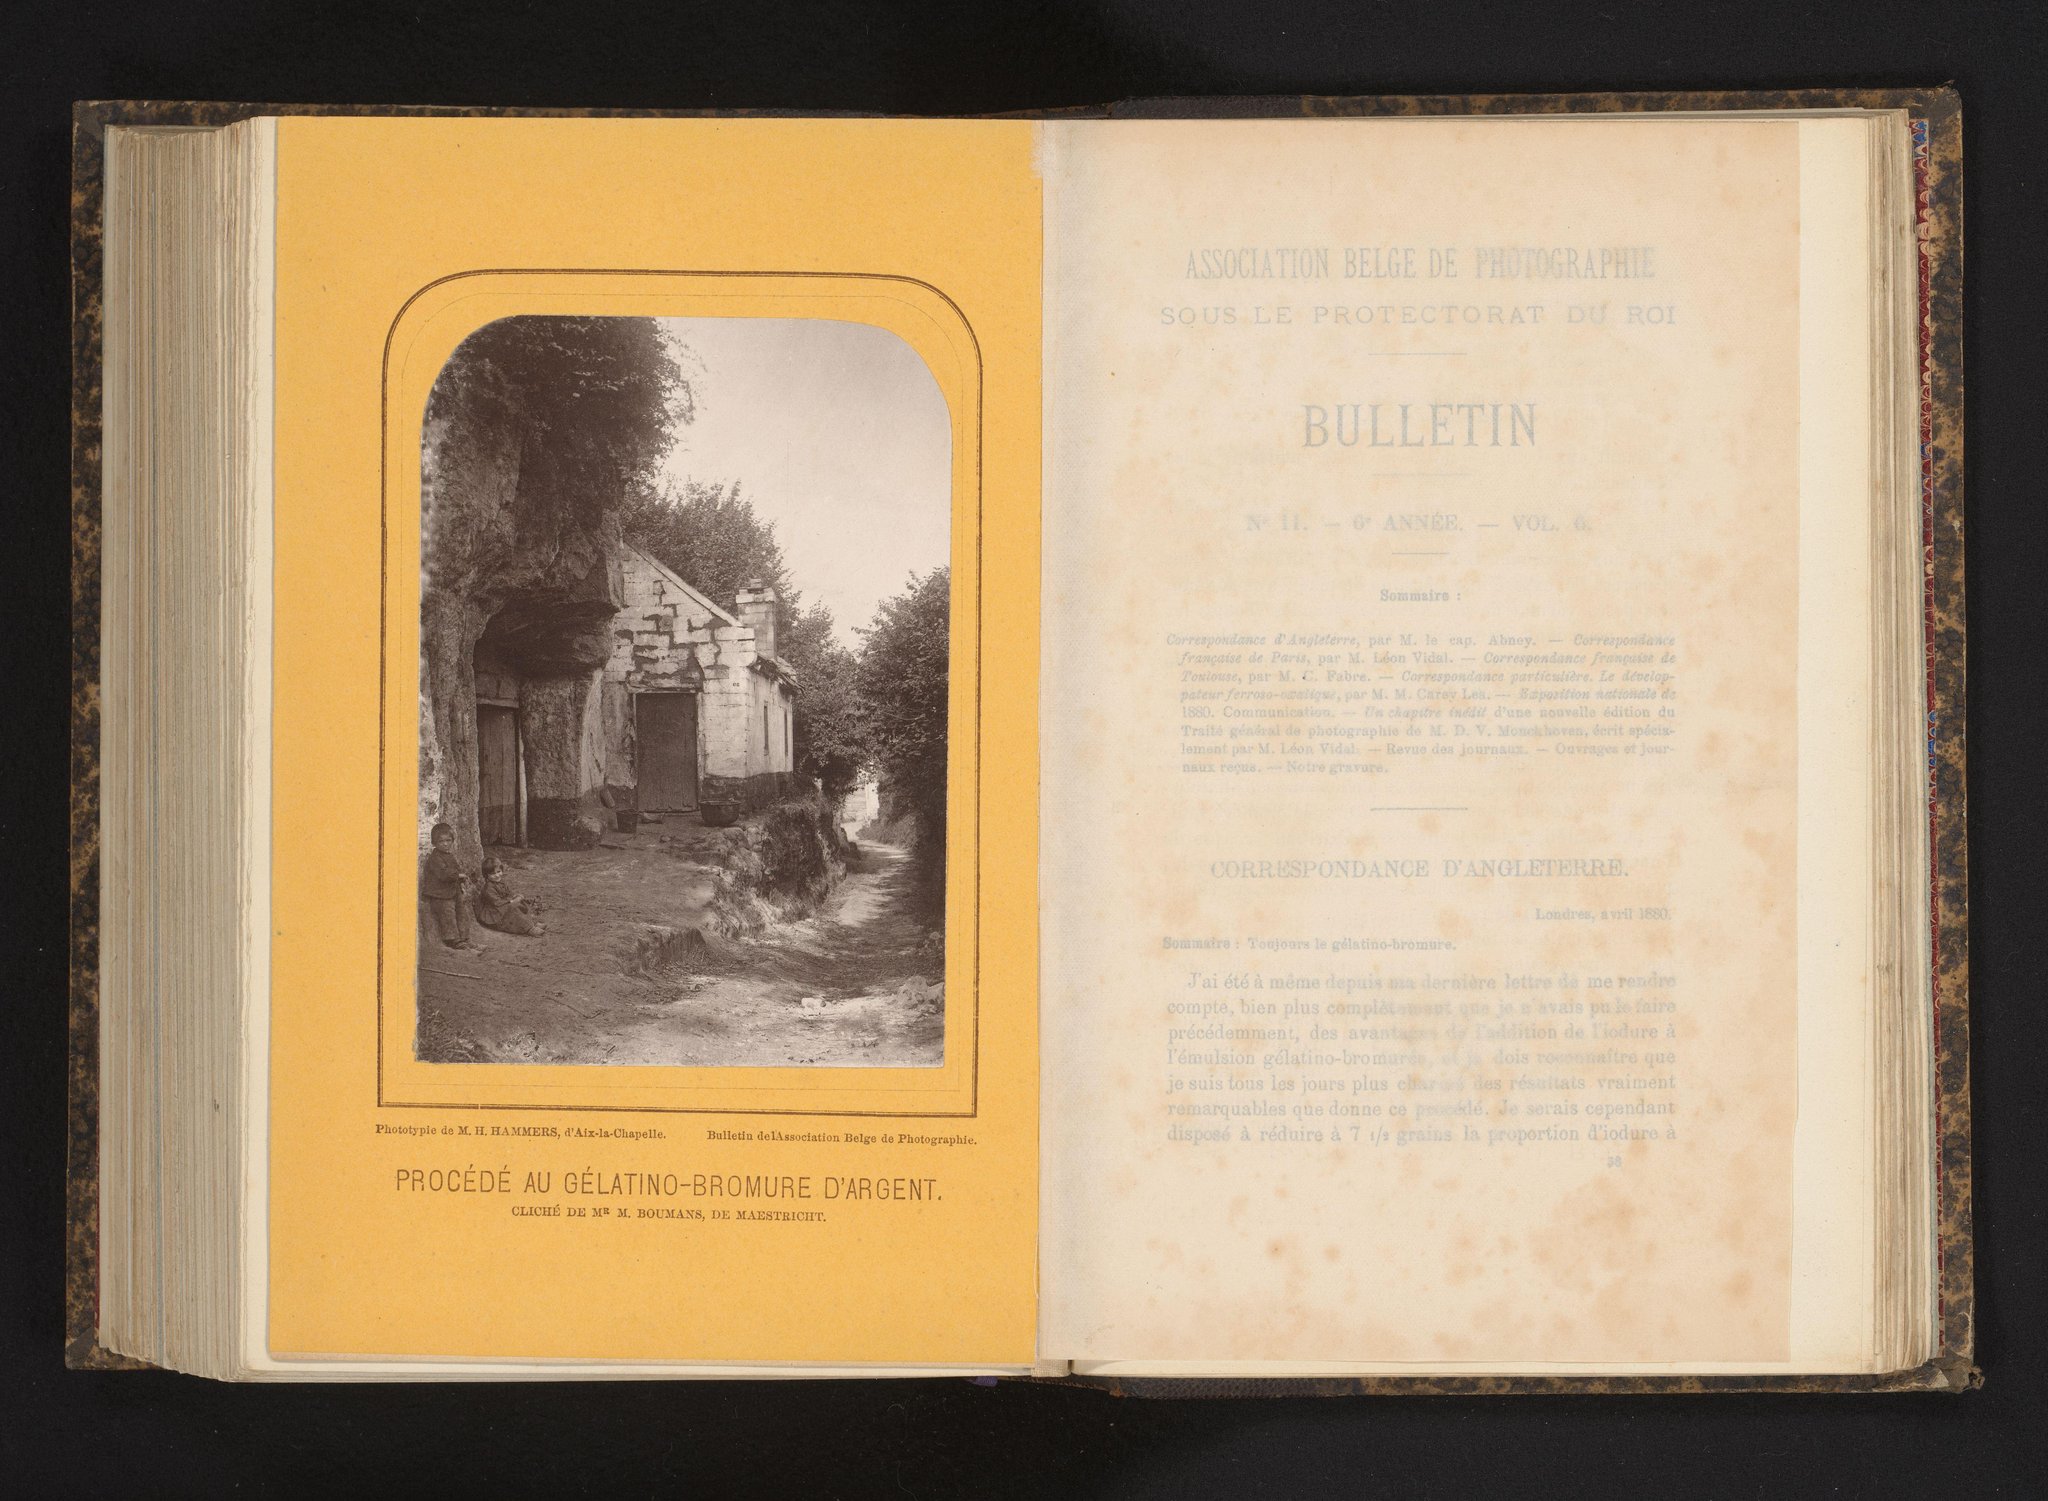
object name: page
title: Twee onbekende kinderen voor een huis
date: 1873-1878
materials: paper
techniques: photograph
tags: toddler, civic architecture; edifices; dwellings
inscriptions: inscription: ‘Procédé au gélatino-bromure d'argent’, inscription: ‘Bulletin de l'Association Belge de Photographie’